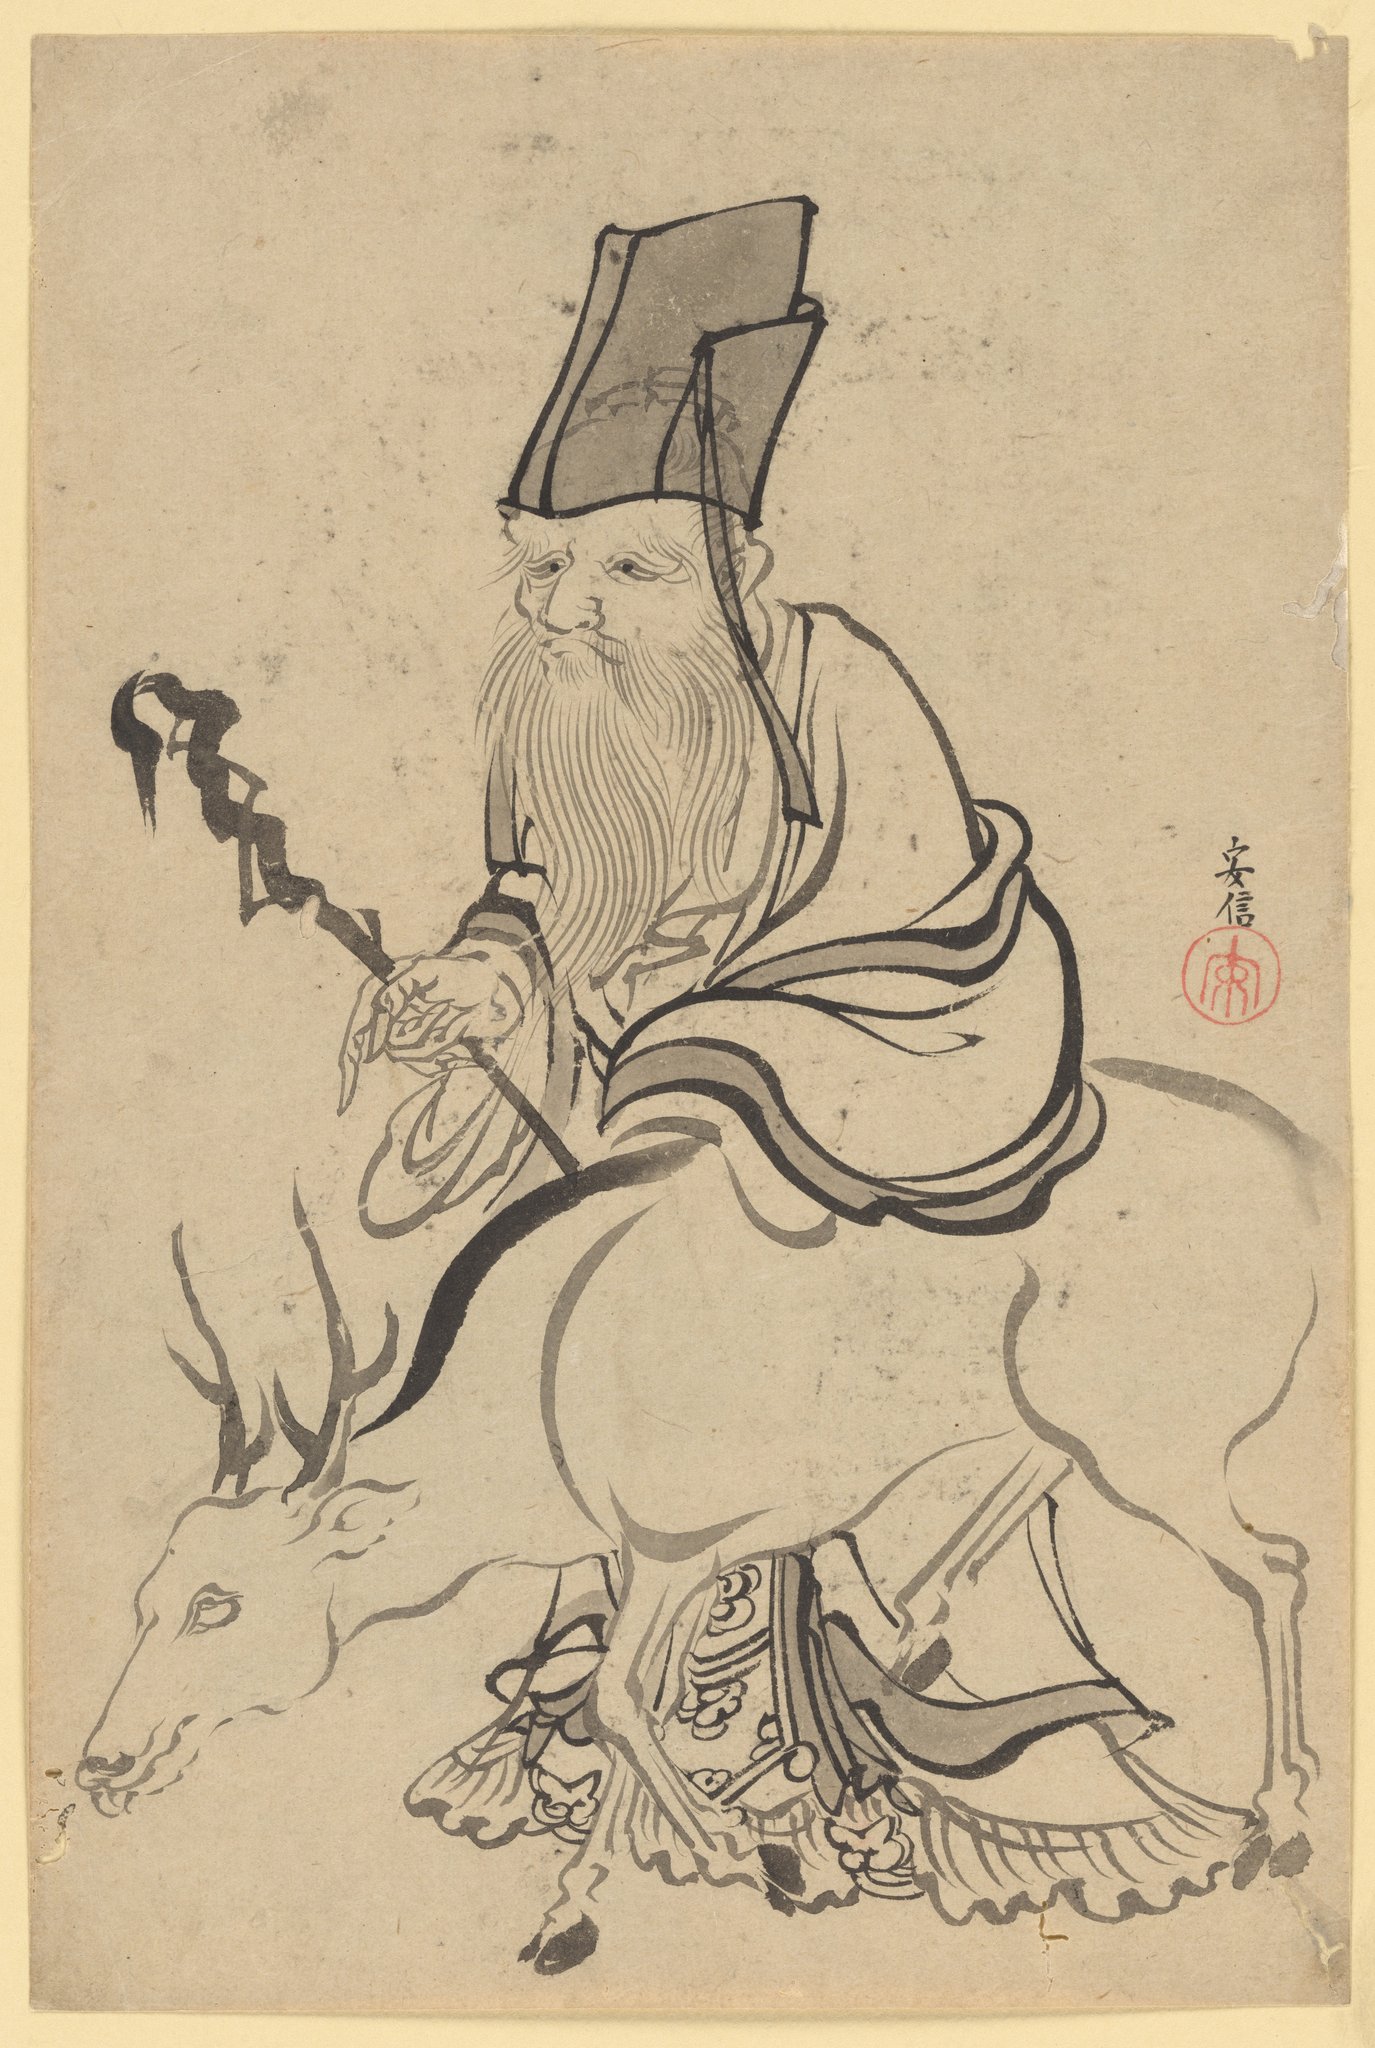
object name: drawing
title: Juro (God of Luck)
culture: japanese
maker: katsushika hokusai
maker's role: artist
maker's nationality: japanese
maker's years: 1760-1849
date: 1701-1900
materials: ink, paper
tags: men,deer